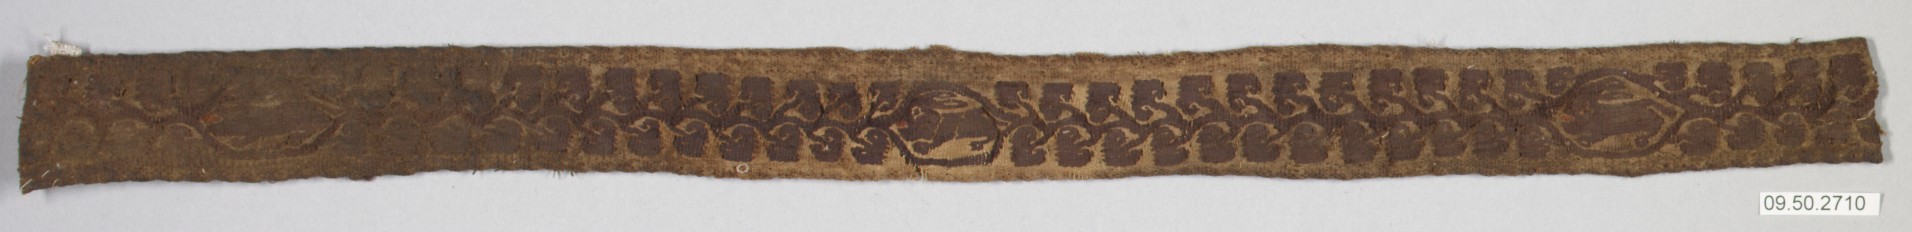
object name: band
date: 201-400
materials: wool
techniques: weave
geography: egypt